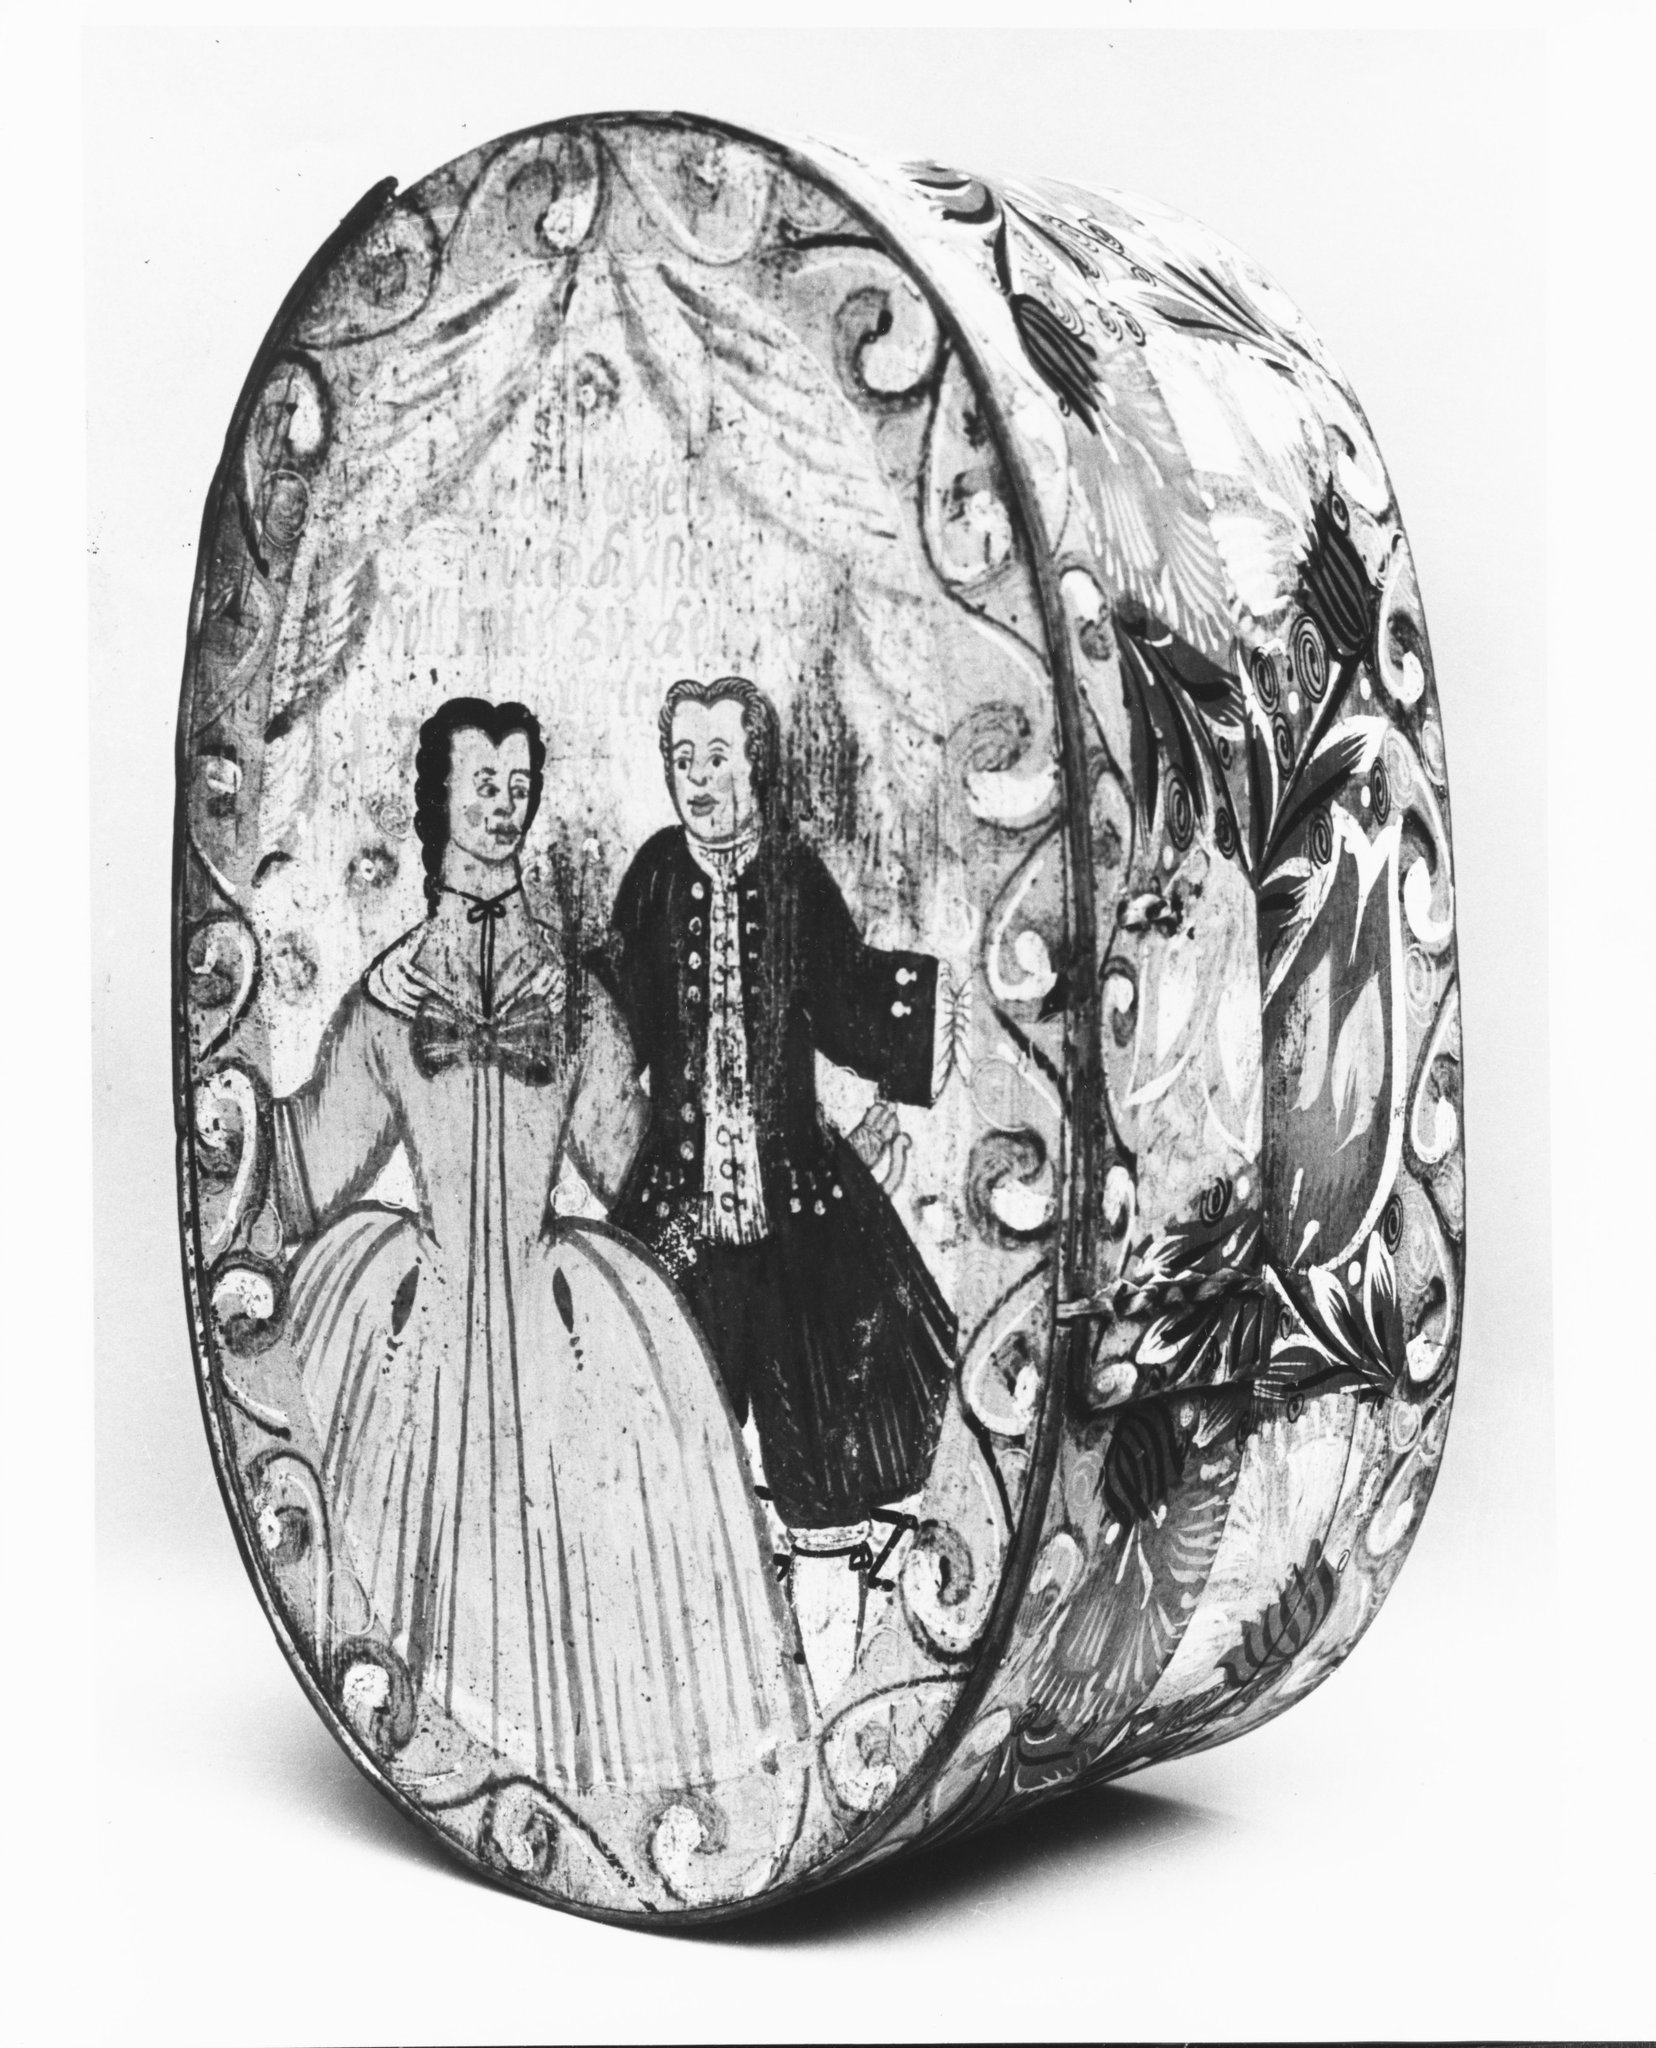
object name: bride box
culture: european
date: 1787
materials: wood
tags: men,women